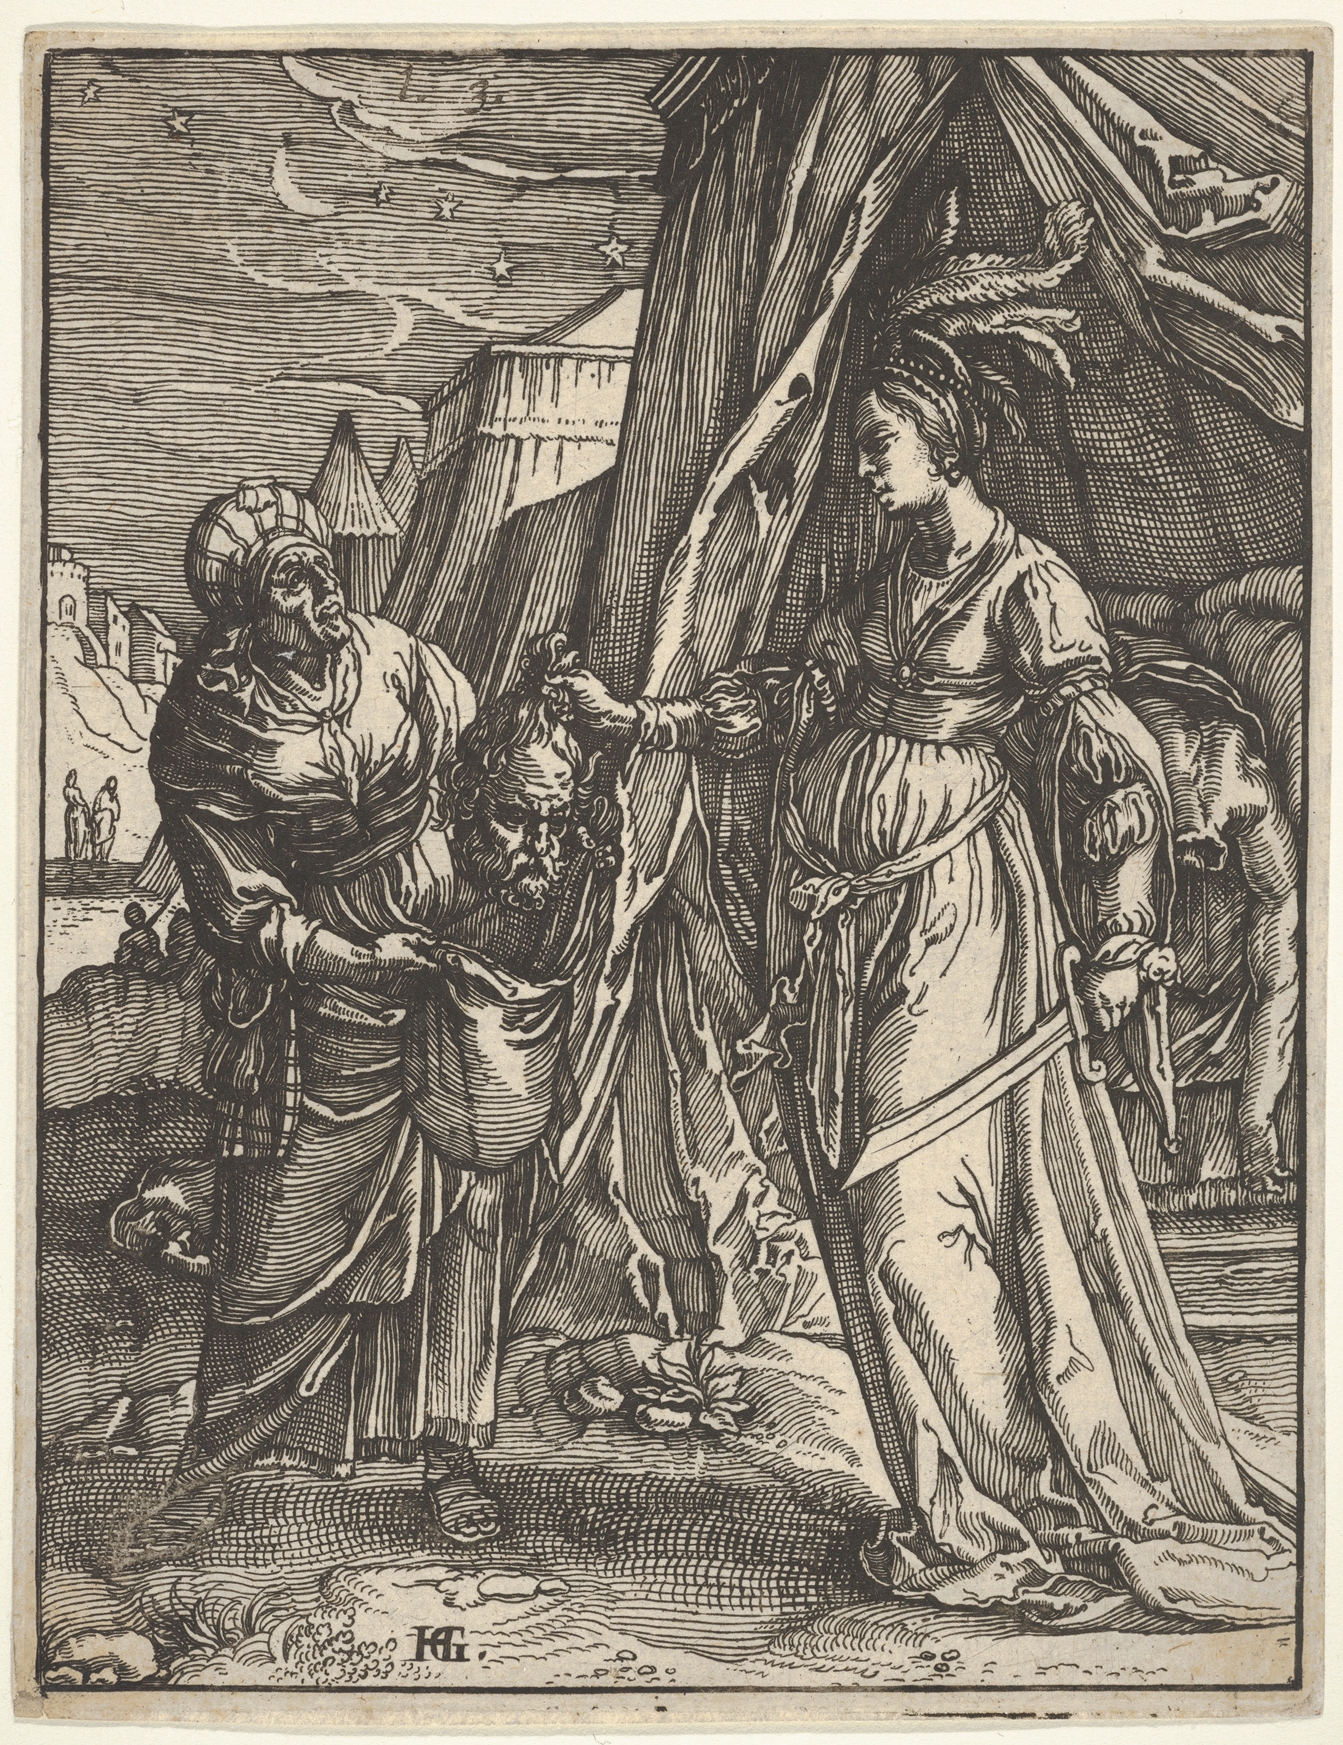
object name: print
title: Judith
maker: claes jansz. visscher (ii)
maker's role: artist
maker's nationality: dutch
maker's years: 1586-1652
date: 1590-1652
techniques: etching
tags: judith